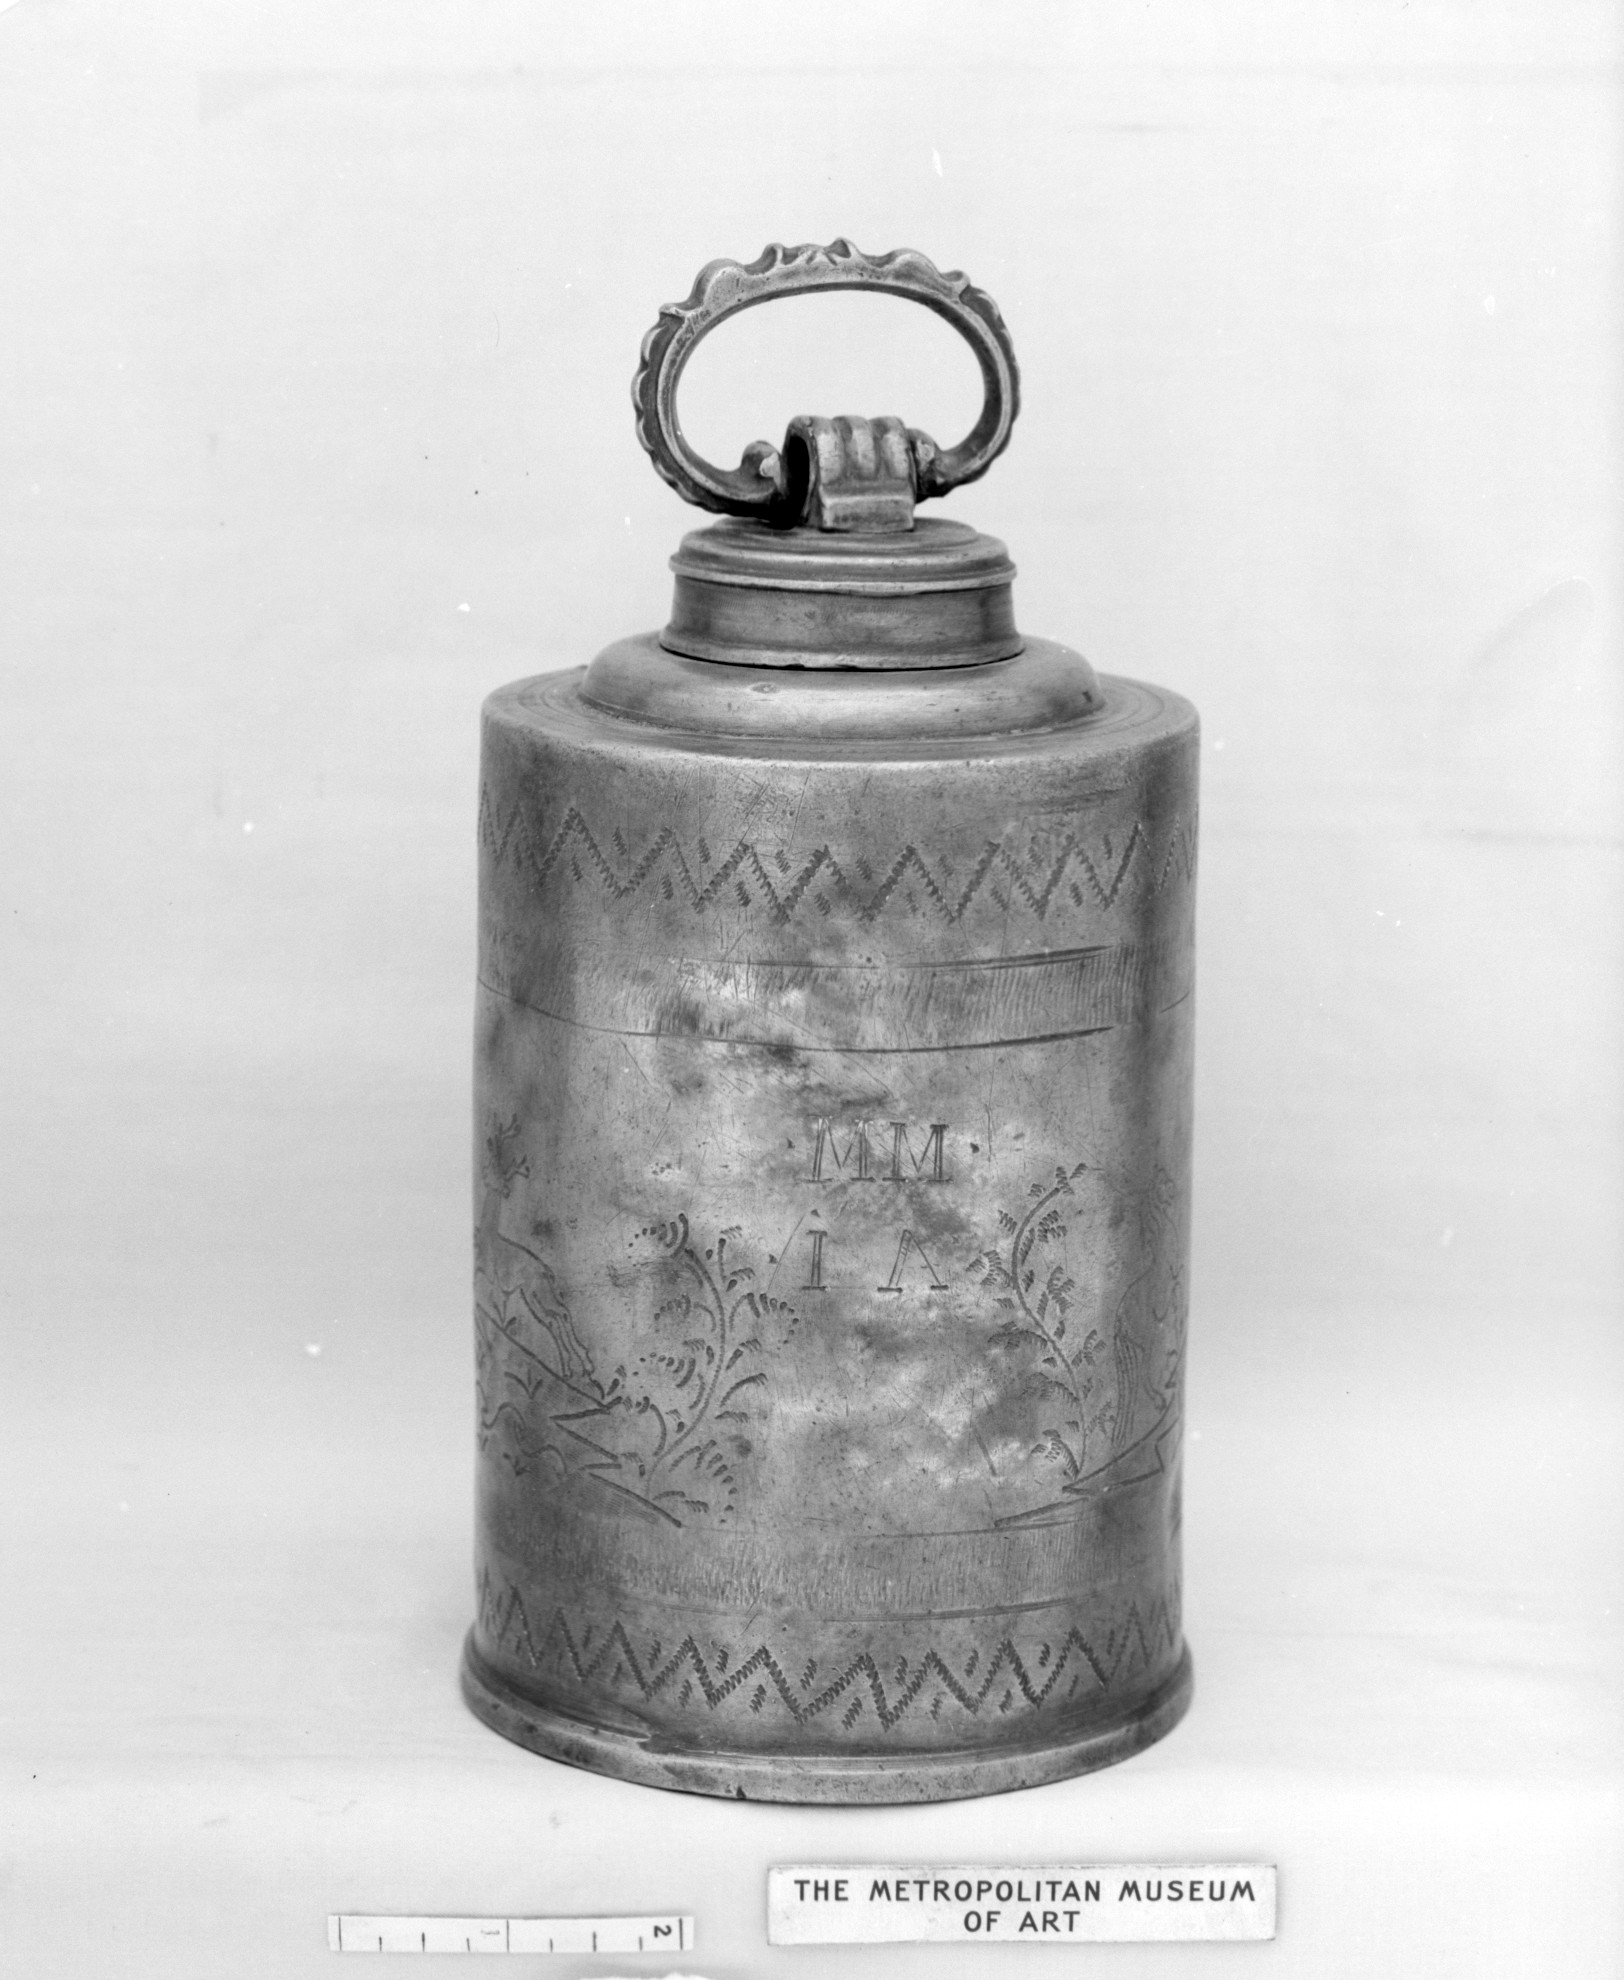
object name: food bottle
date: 1651-1700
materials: pewter